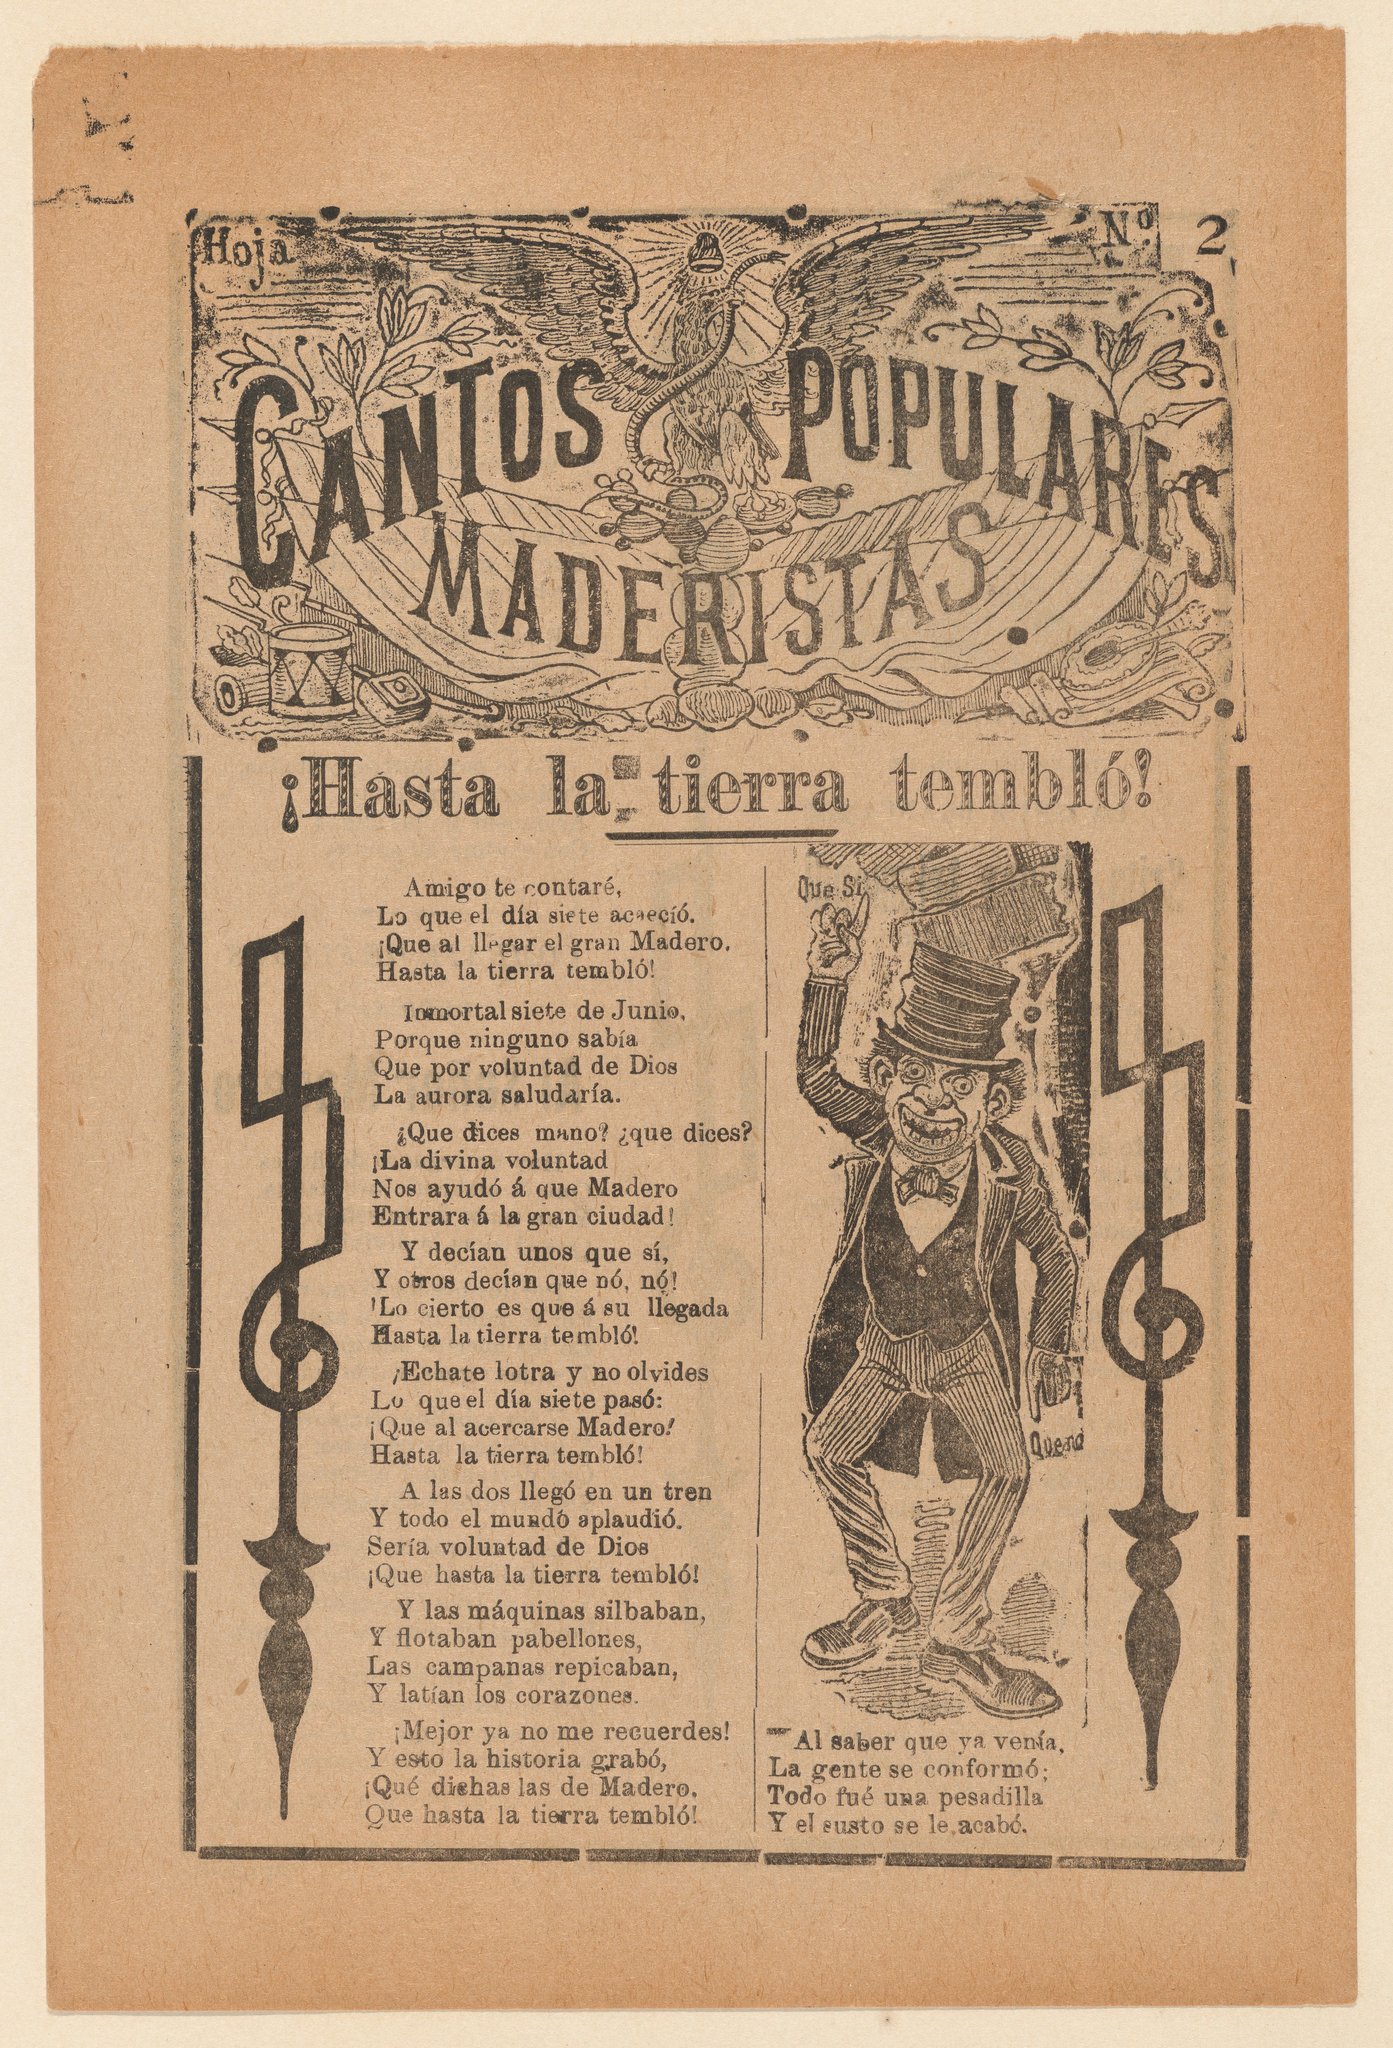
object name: print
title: Broadsheet celebrating one of the founders of the Mexican Revolution, Francisco Madero, shown in a suit and top hat pointing to the phrases 'Que Si' and 'Que No'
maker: josé guadalupe posada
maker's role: artist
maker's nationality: mexican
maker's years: 1852-1913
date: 1911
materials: paper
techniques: letterpress, lithography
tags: men